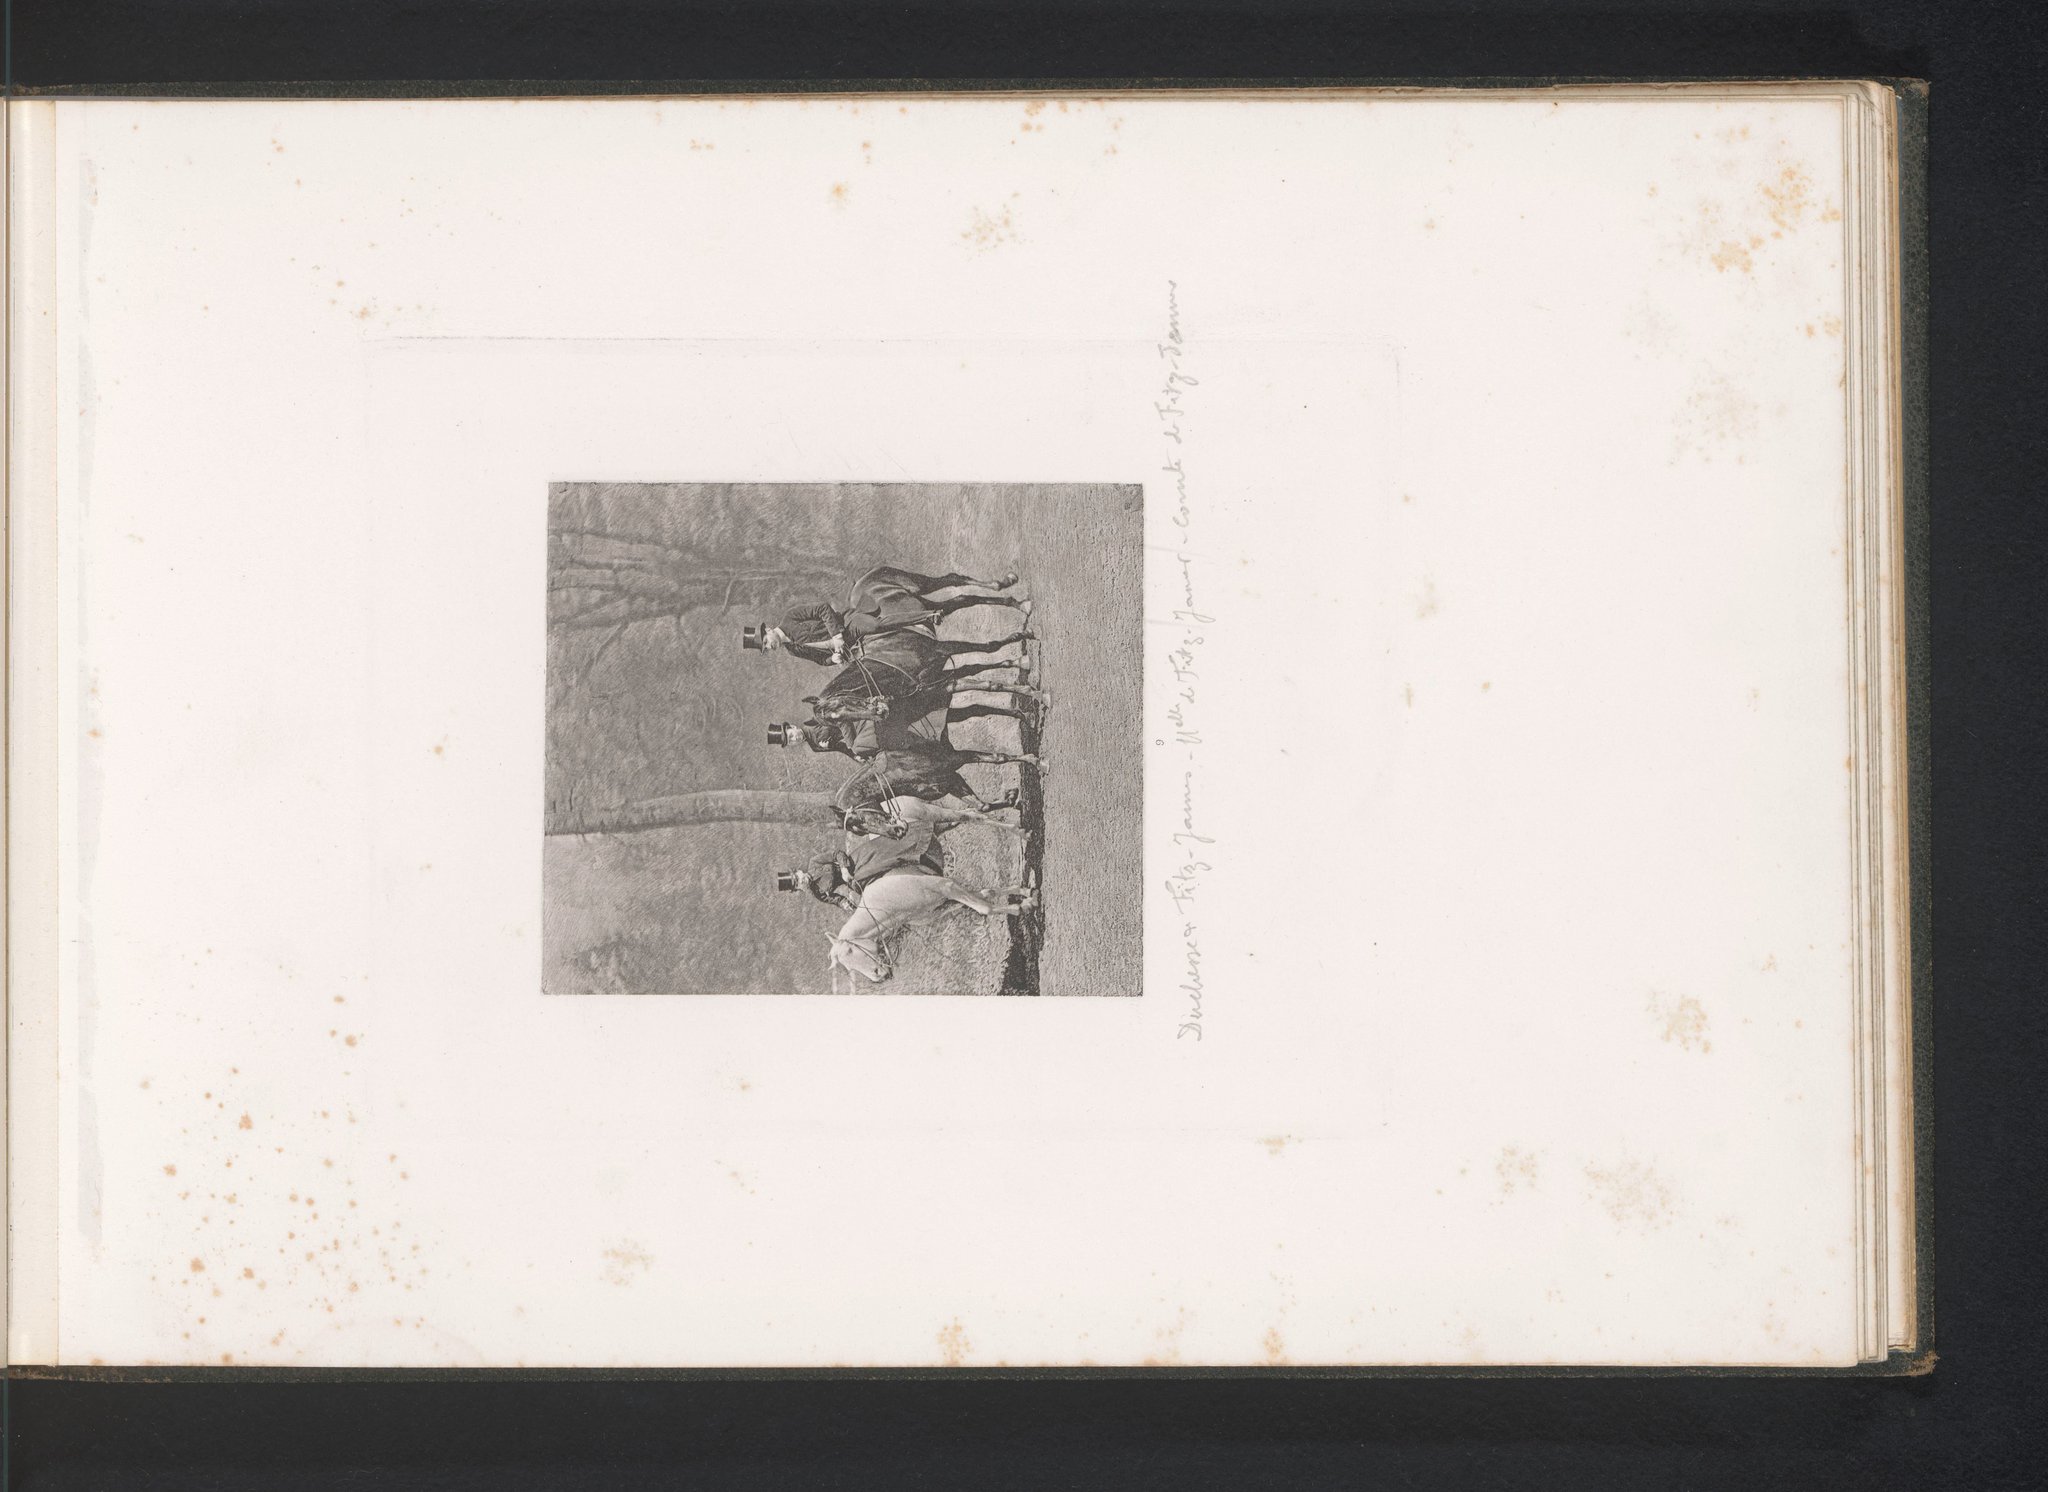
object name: page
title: Drie ruiters te paard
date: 1874-1884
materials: paper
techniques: photoaquatint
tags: riding a horse, ass, or mule; rider, horseman, head-gear: top hat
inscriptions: inscription: ‘Duchesse de Fitz-James - Mlle de Fitz-James - Comte de Fitz-James’, number: ‘9’